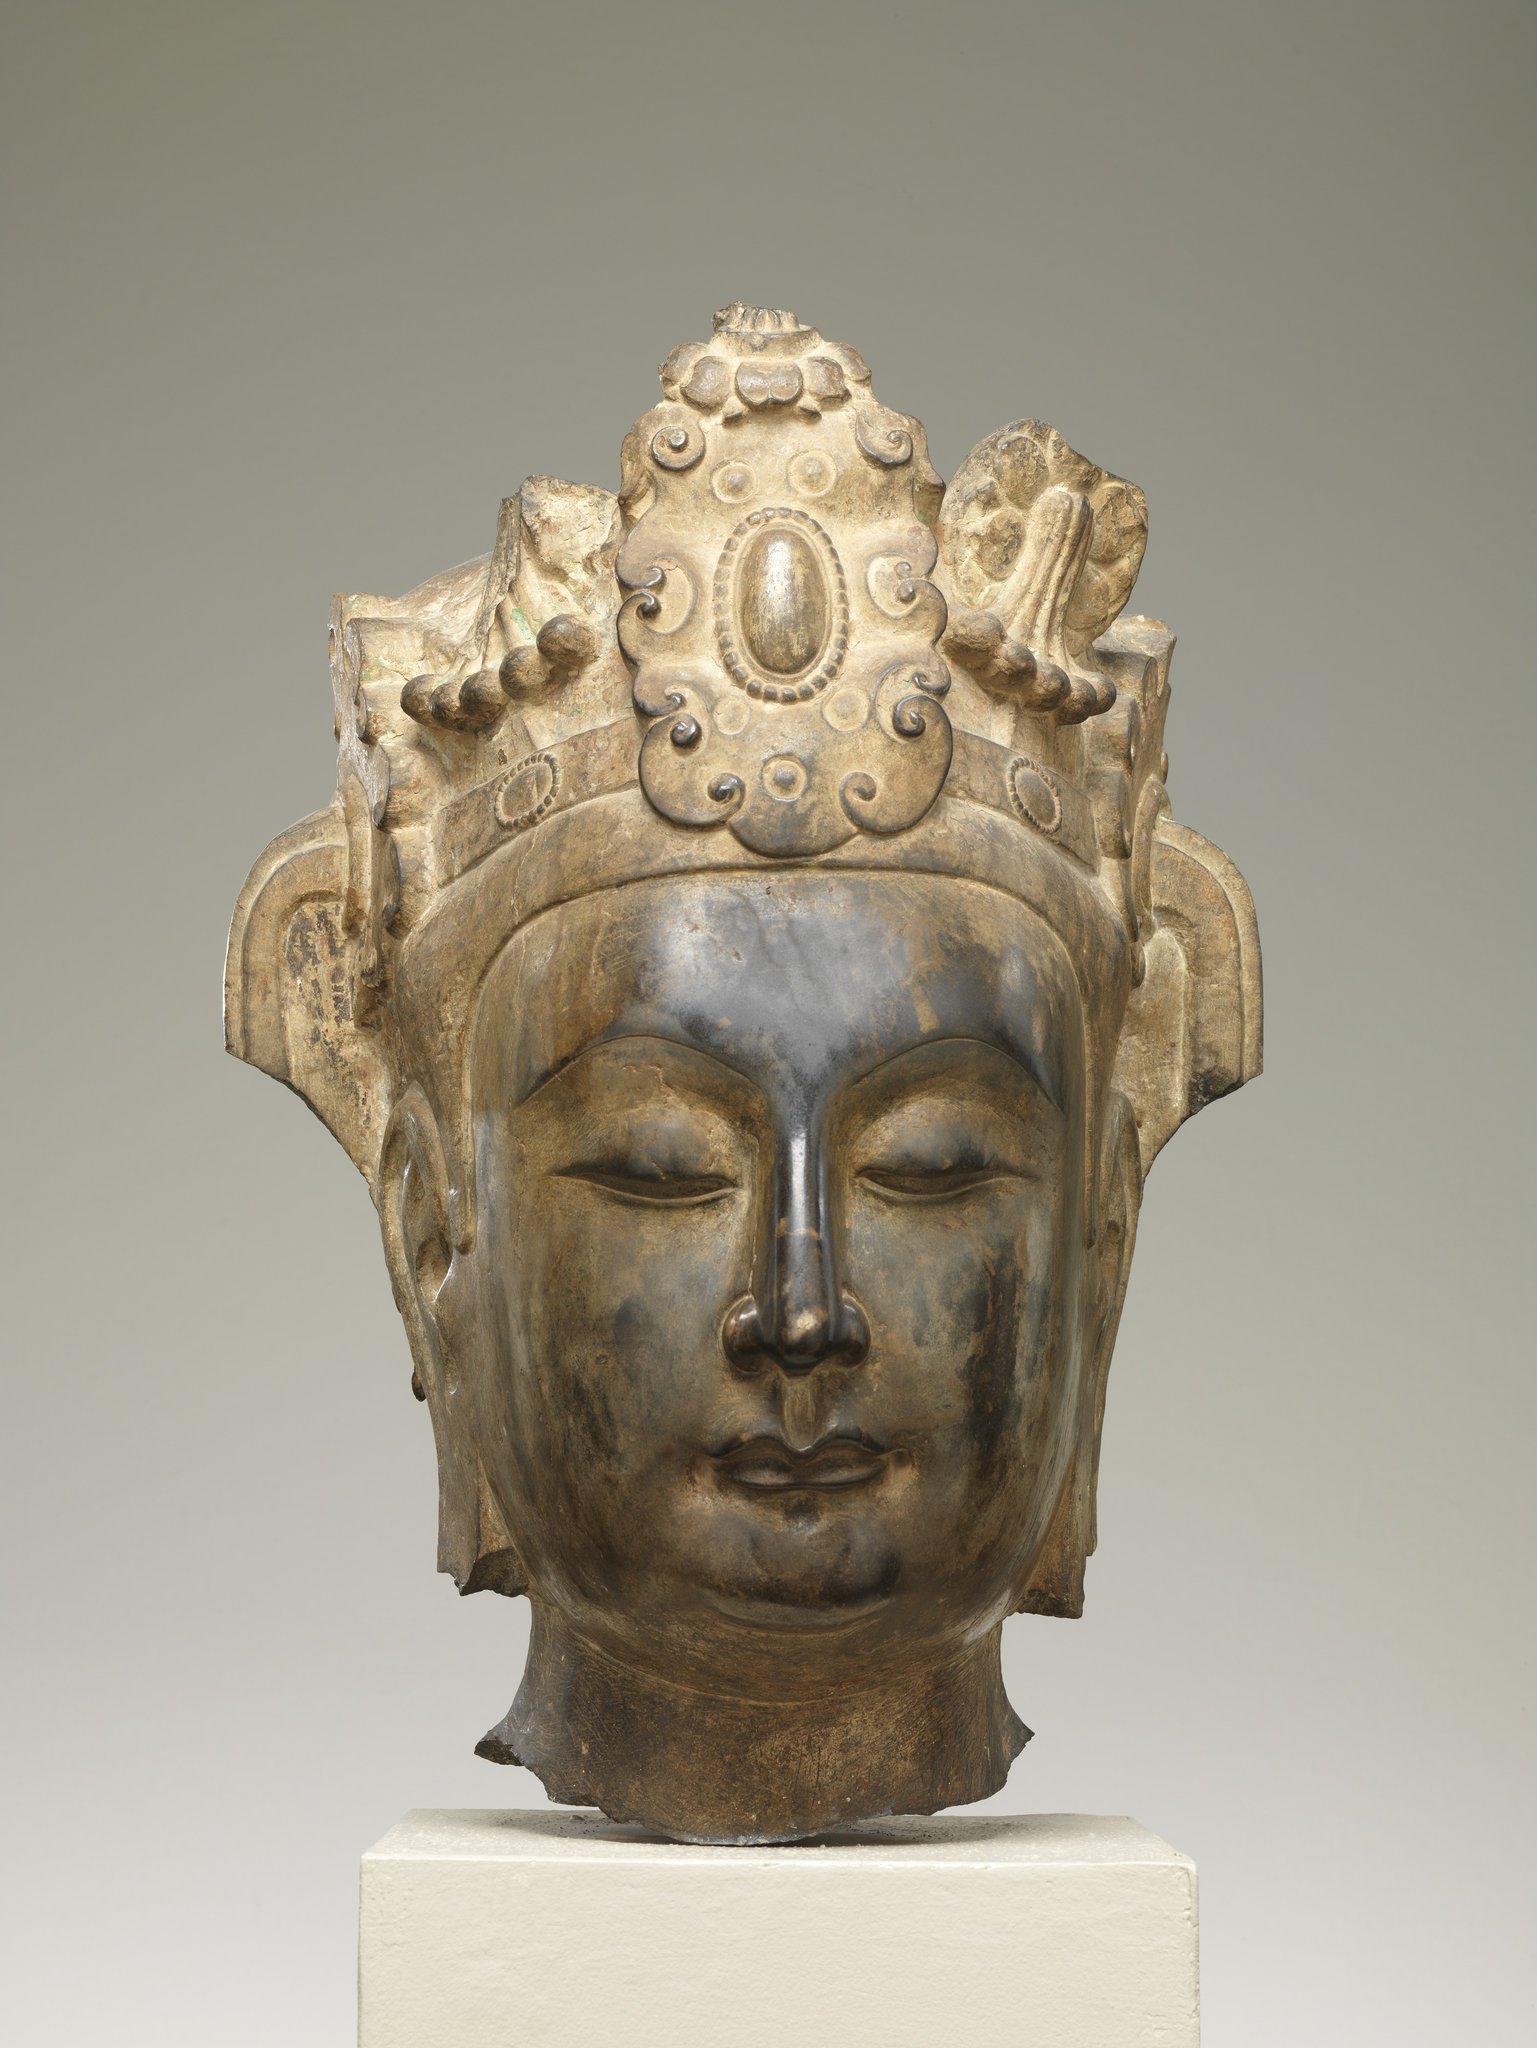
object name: head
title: Head of an attendant bodhisattva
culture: chinese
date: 565-575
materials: limestone, pigment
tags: heads,buddhism,bodhisattvas